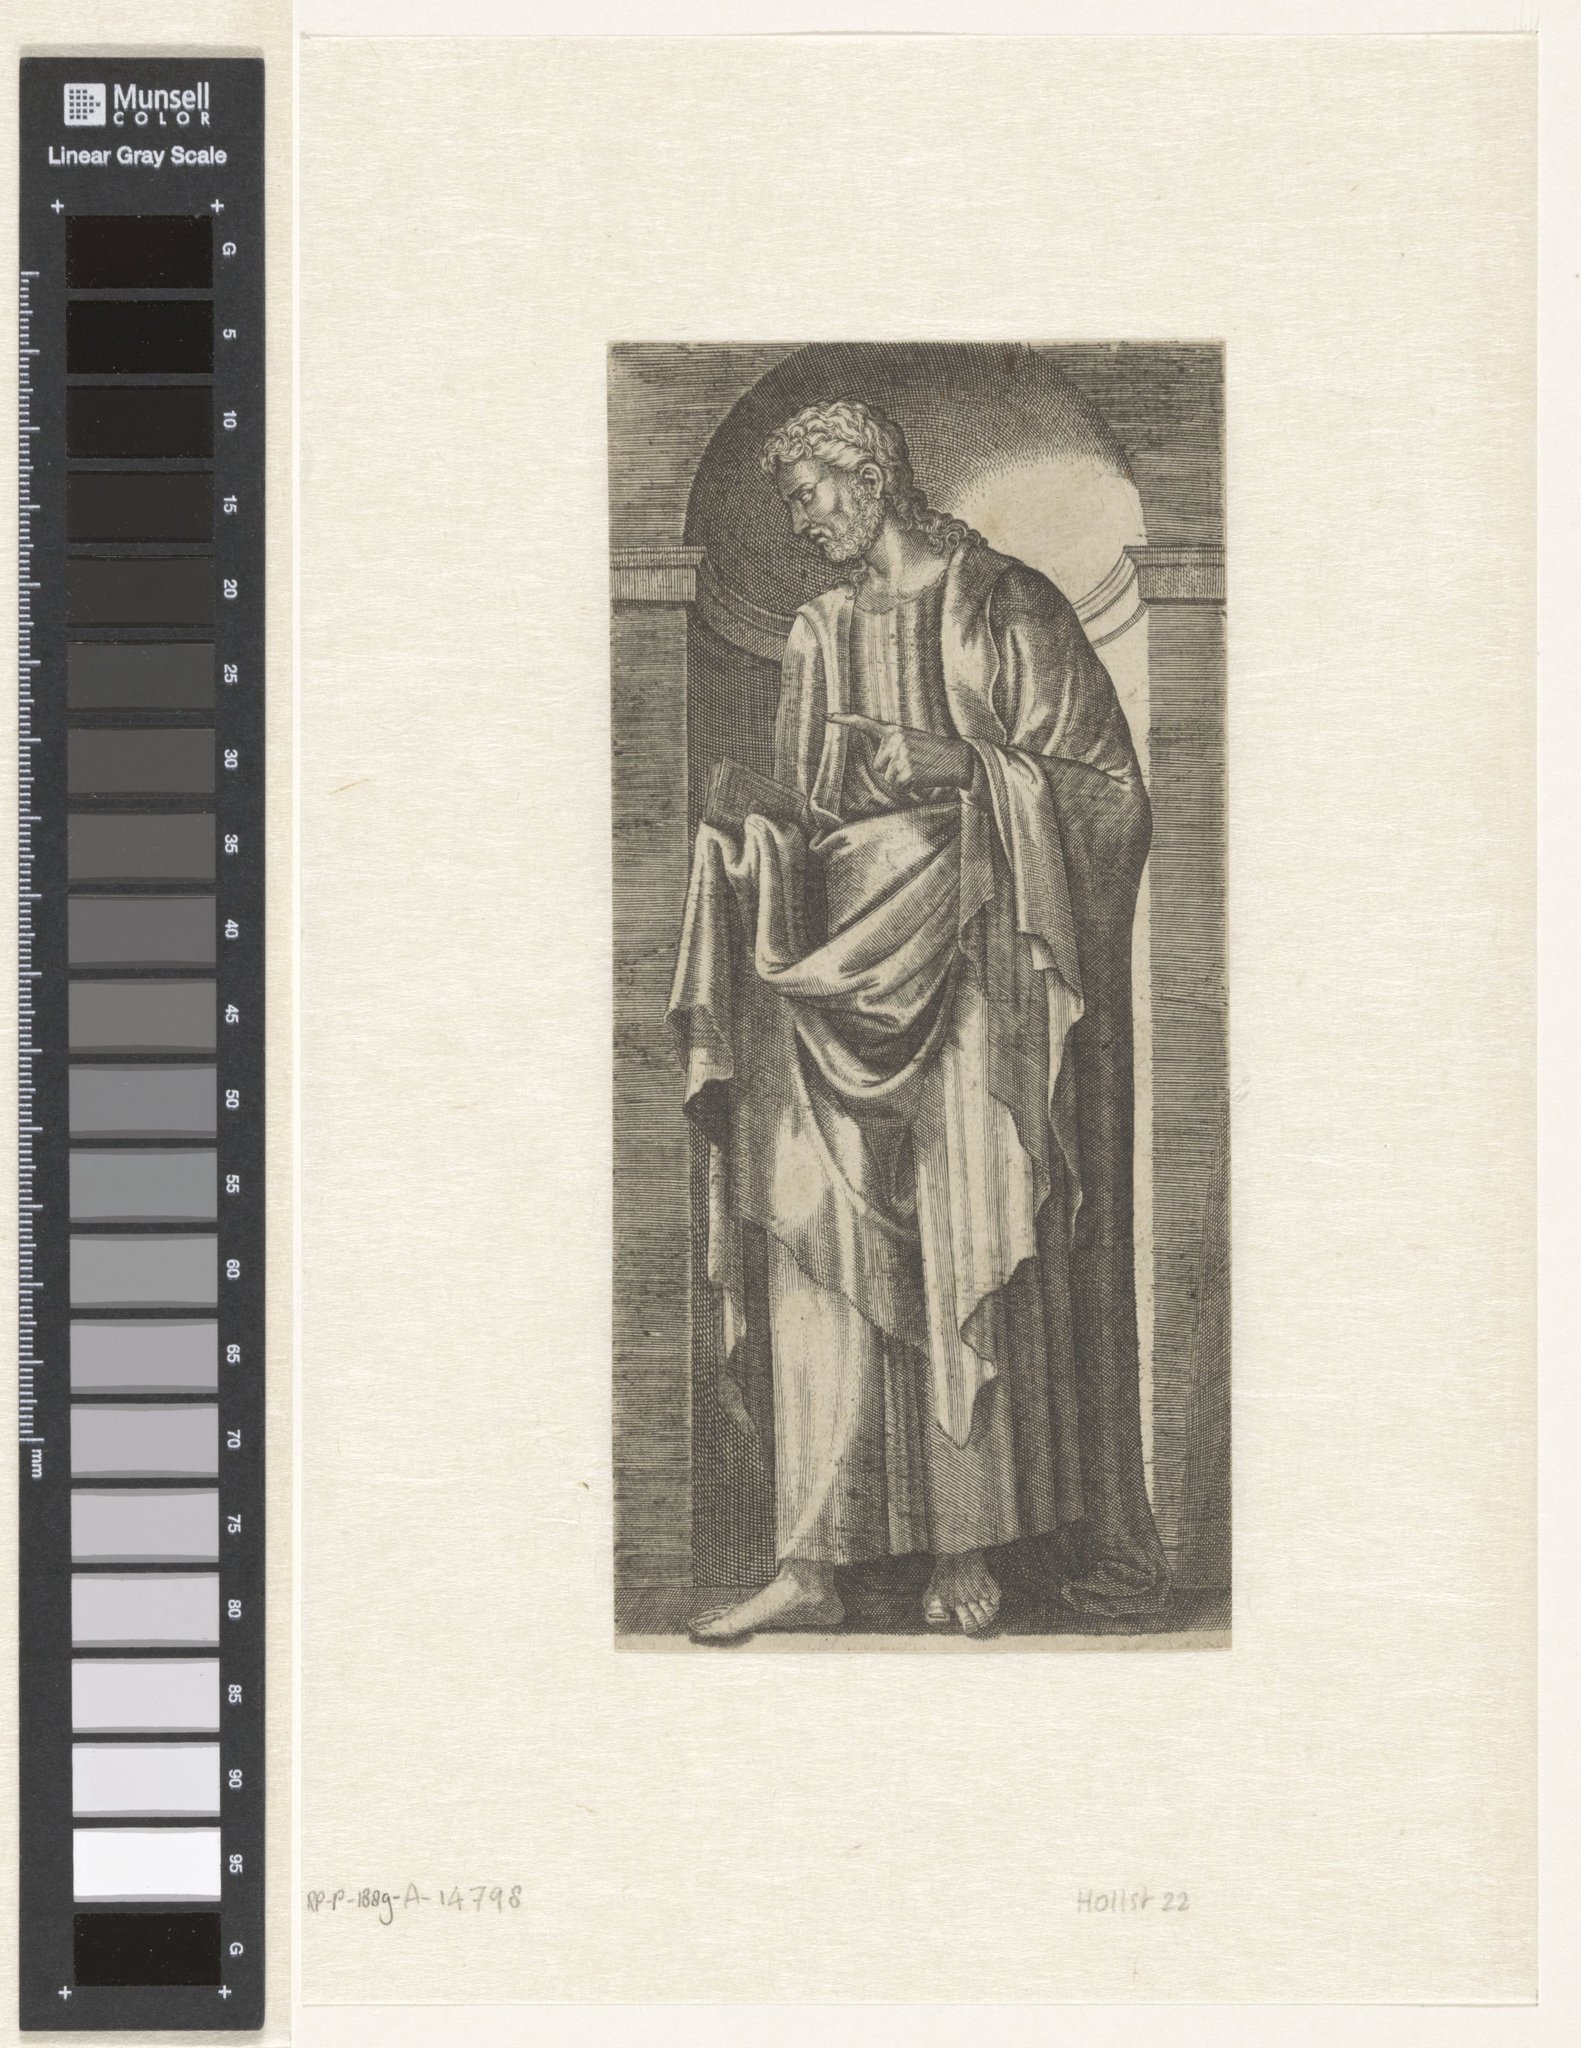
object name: print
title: Apostel Tomas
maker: lambertus suavius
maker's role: print maker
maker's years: 1514-1564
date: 1545-1548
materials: paper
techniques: engraving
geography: southern netherlands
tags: the apostle thomas; possible attributes: book, chalice, girdle, heart, lance or spear, scroll, square, stones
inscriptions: collector's mark: Lugt 2228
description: De apostel Tomas staande in een nis met een boek in de ene hand en wijzend met zijn andere hand.